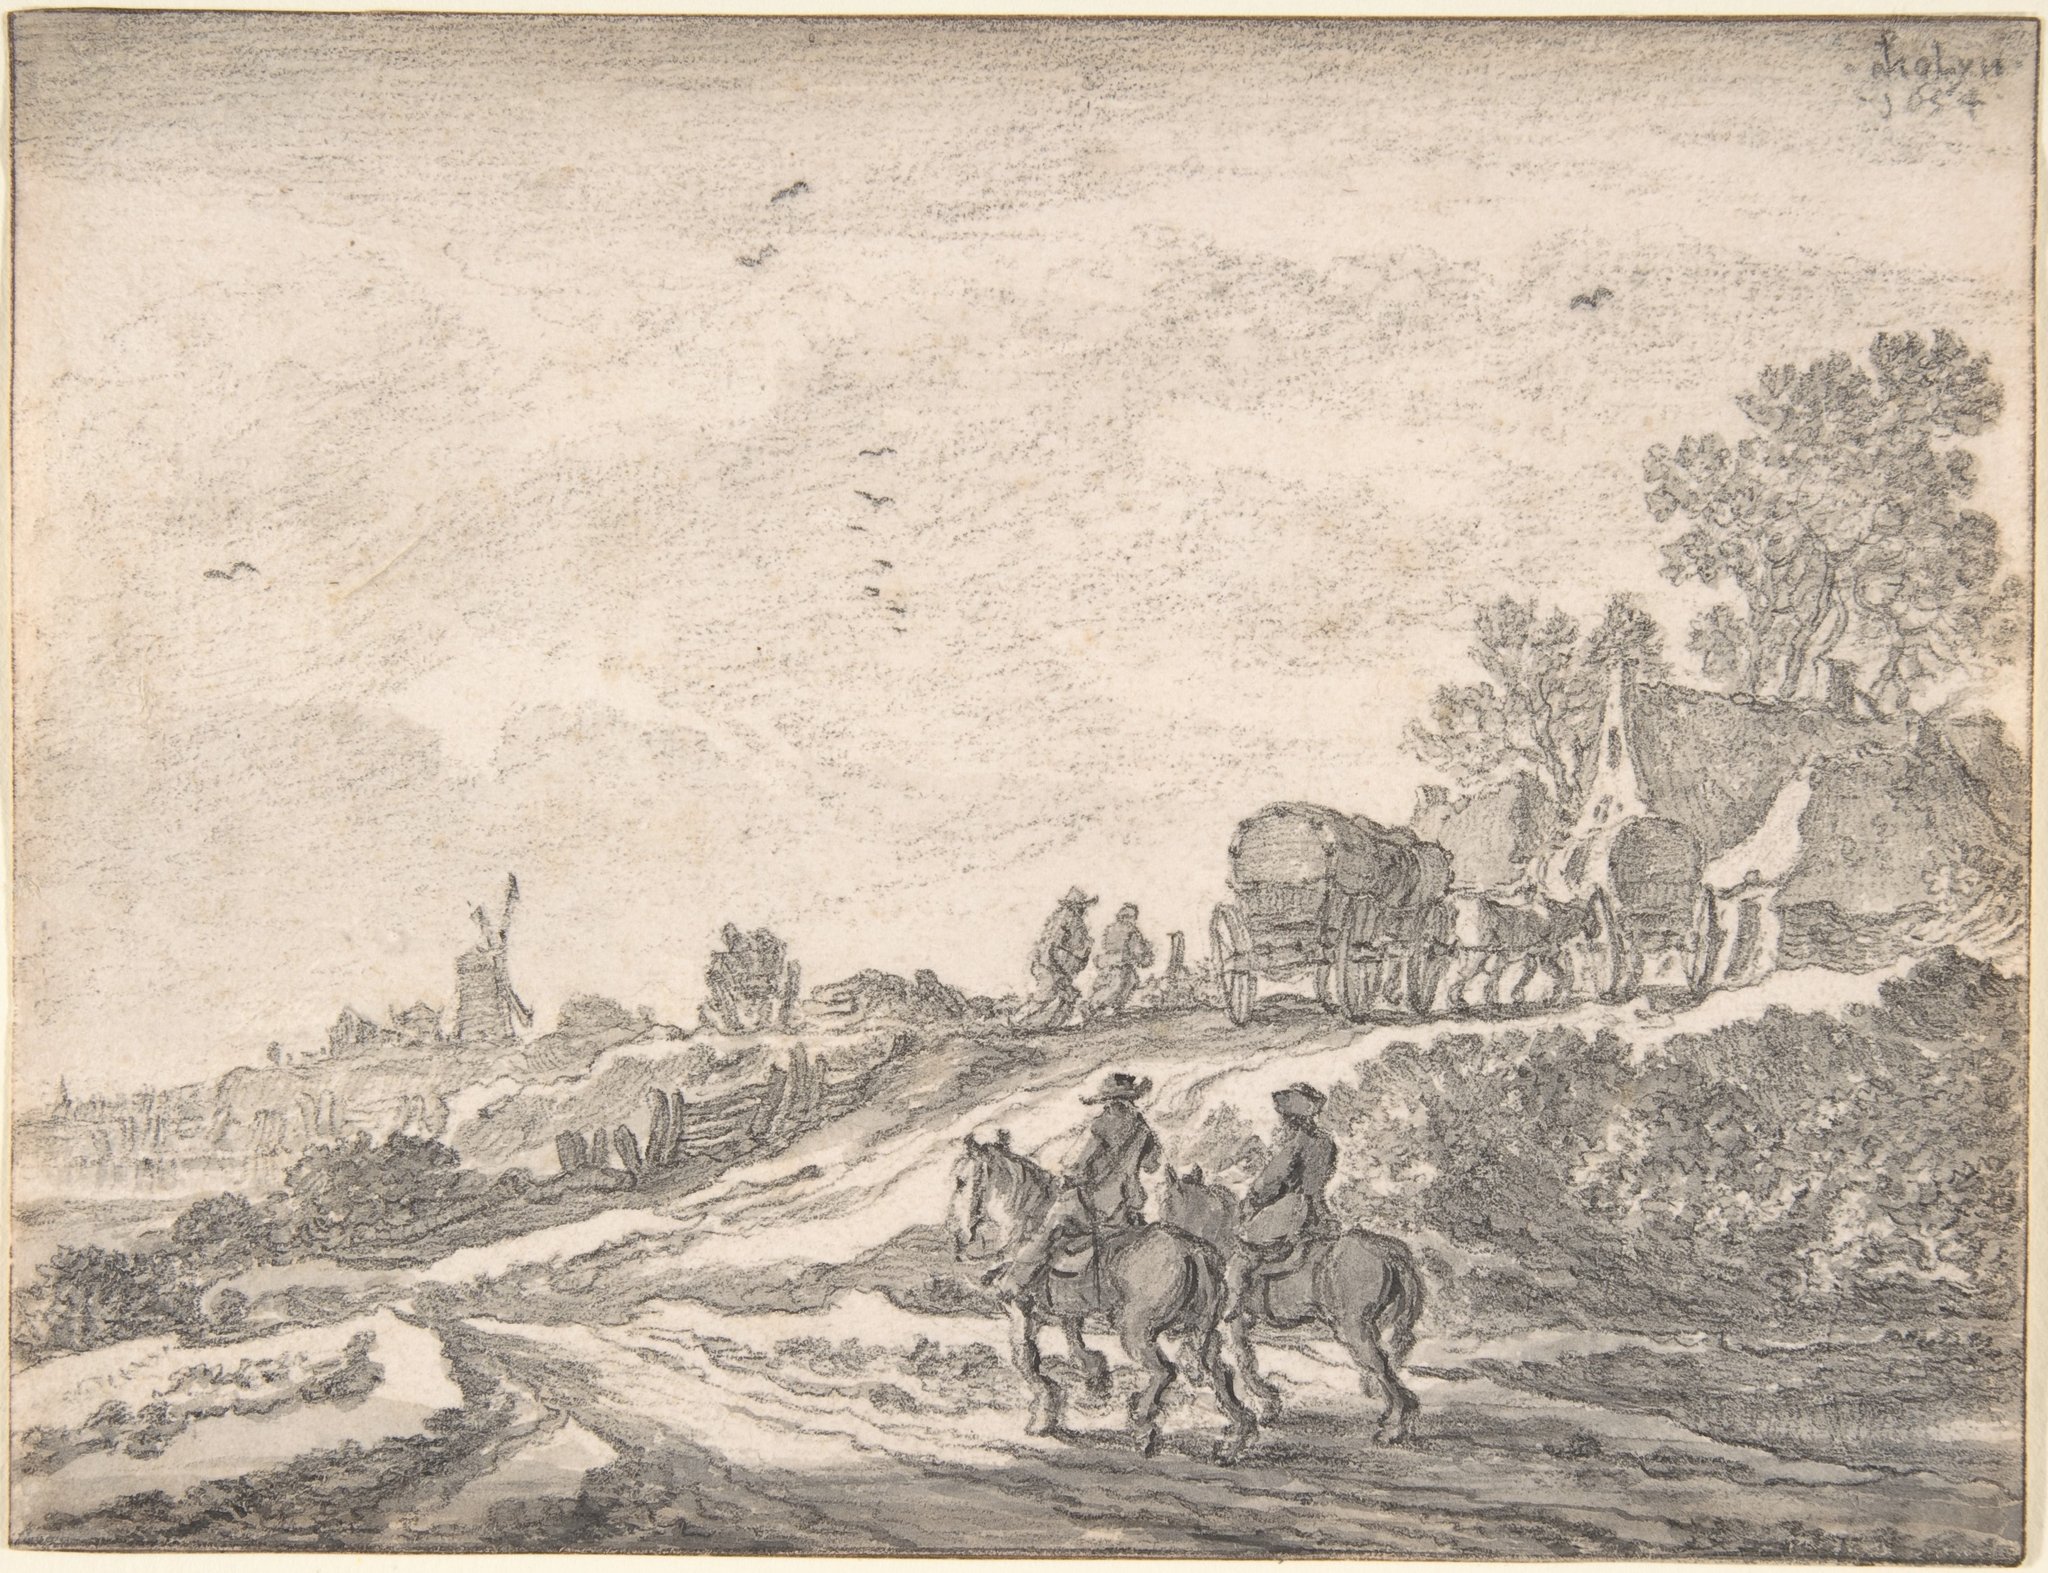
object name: drawing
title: Landscape with Two Men on Horseback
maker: pieter de molijn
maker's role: artist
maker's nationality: dutch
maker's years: 1595-1661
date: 1654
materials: chalk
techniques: wash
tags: men,horses,landscapes,carriages